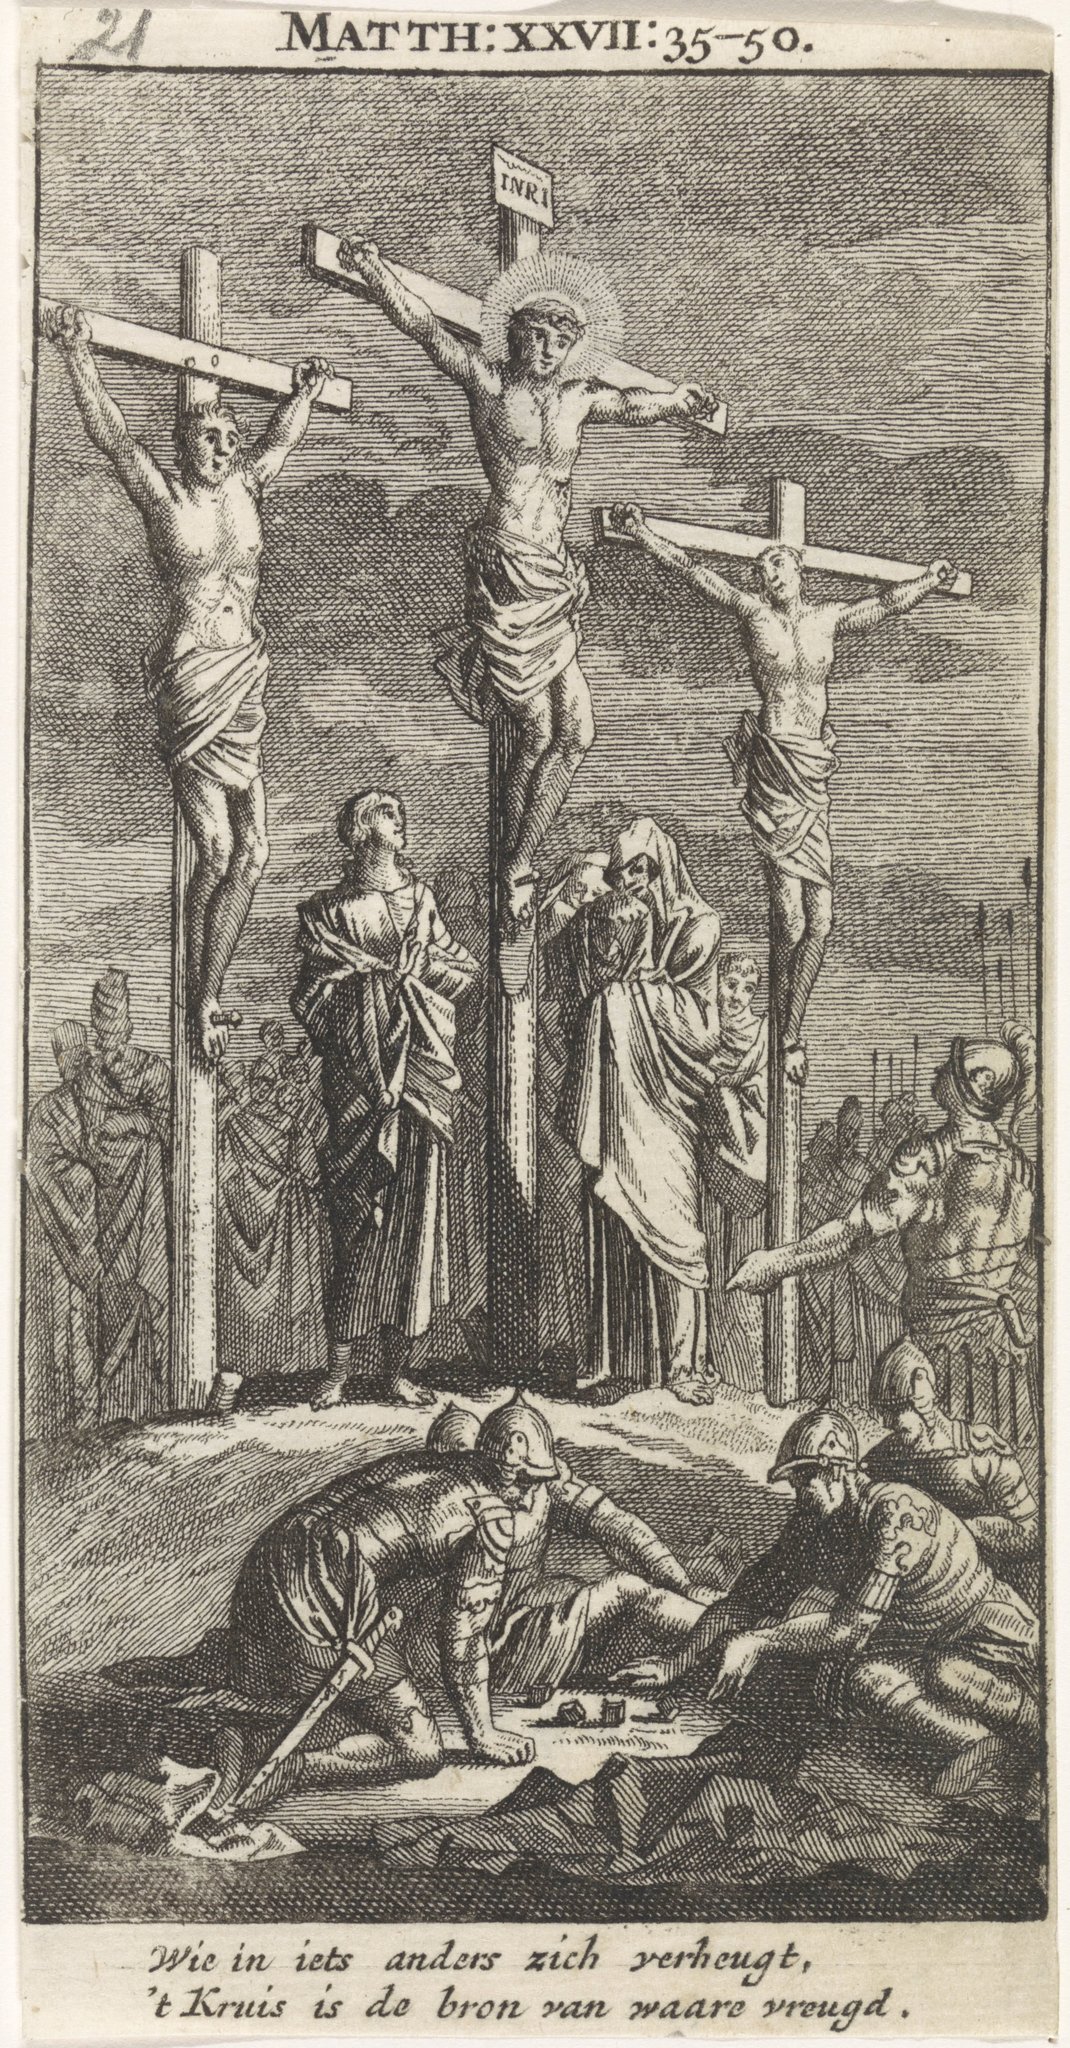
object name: print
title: Drie kruisen op Golgotha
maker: Anonymous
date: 1712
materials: paper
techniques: etching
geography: amsterdam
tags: comprehensive representations of the events on golgotha during christ's hanging on the cross, no particular event emphasized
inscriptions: collector's mark: Lugt 2228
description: Kopie naar illustratie voor: Luyken, Jan. Bybel printen. Amsterdam: Pieter Arentsz. II (wed.) en Cornelis van der Sys, 1712, p. 21.